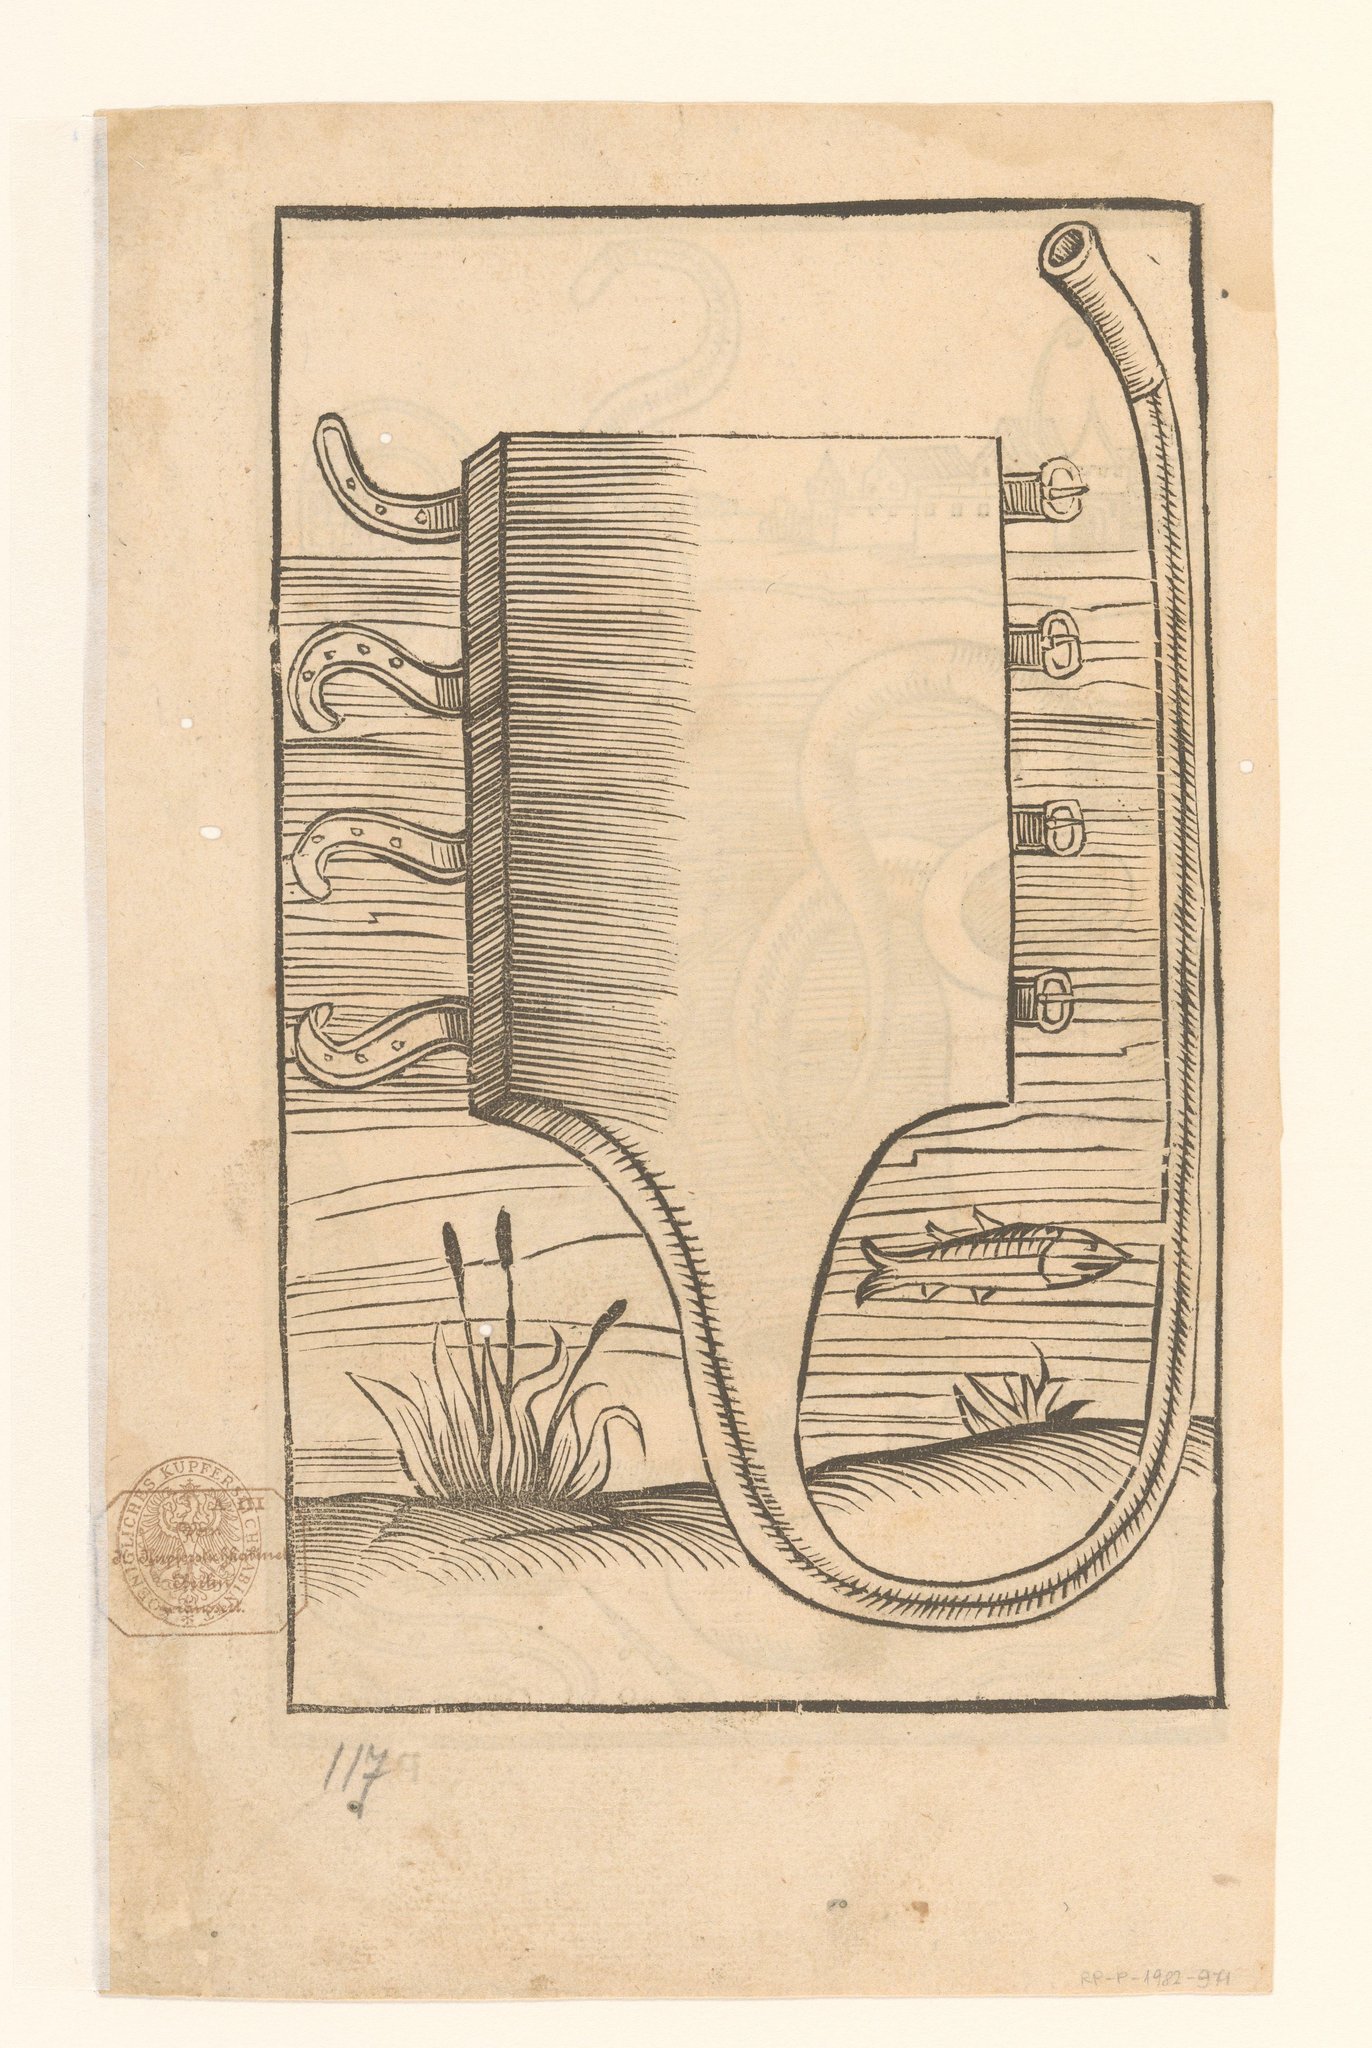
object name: book illustration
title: Ademluchtfles voor gebruik tijdens het duiken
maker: Anonymous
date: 1474-1535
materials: paper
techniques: woodcut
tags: diving (sport), fishes, water course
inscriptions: collector's mark: Lugt 1609, collector's mark: Lugt 2760, collector's mark: Lugt 2228, collector's mark: Lugt 4957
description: De prent komt uit een editie van het vierde deel van De re militari of Epitoma rei militaris, door Publius Flavius Vegetius Renatus. Vermoedelijk komt de prent uit een van de edities tussen 1474 en 1535.